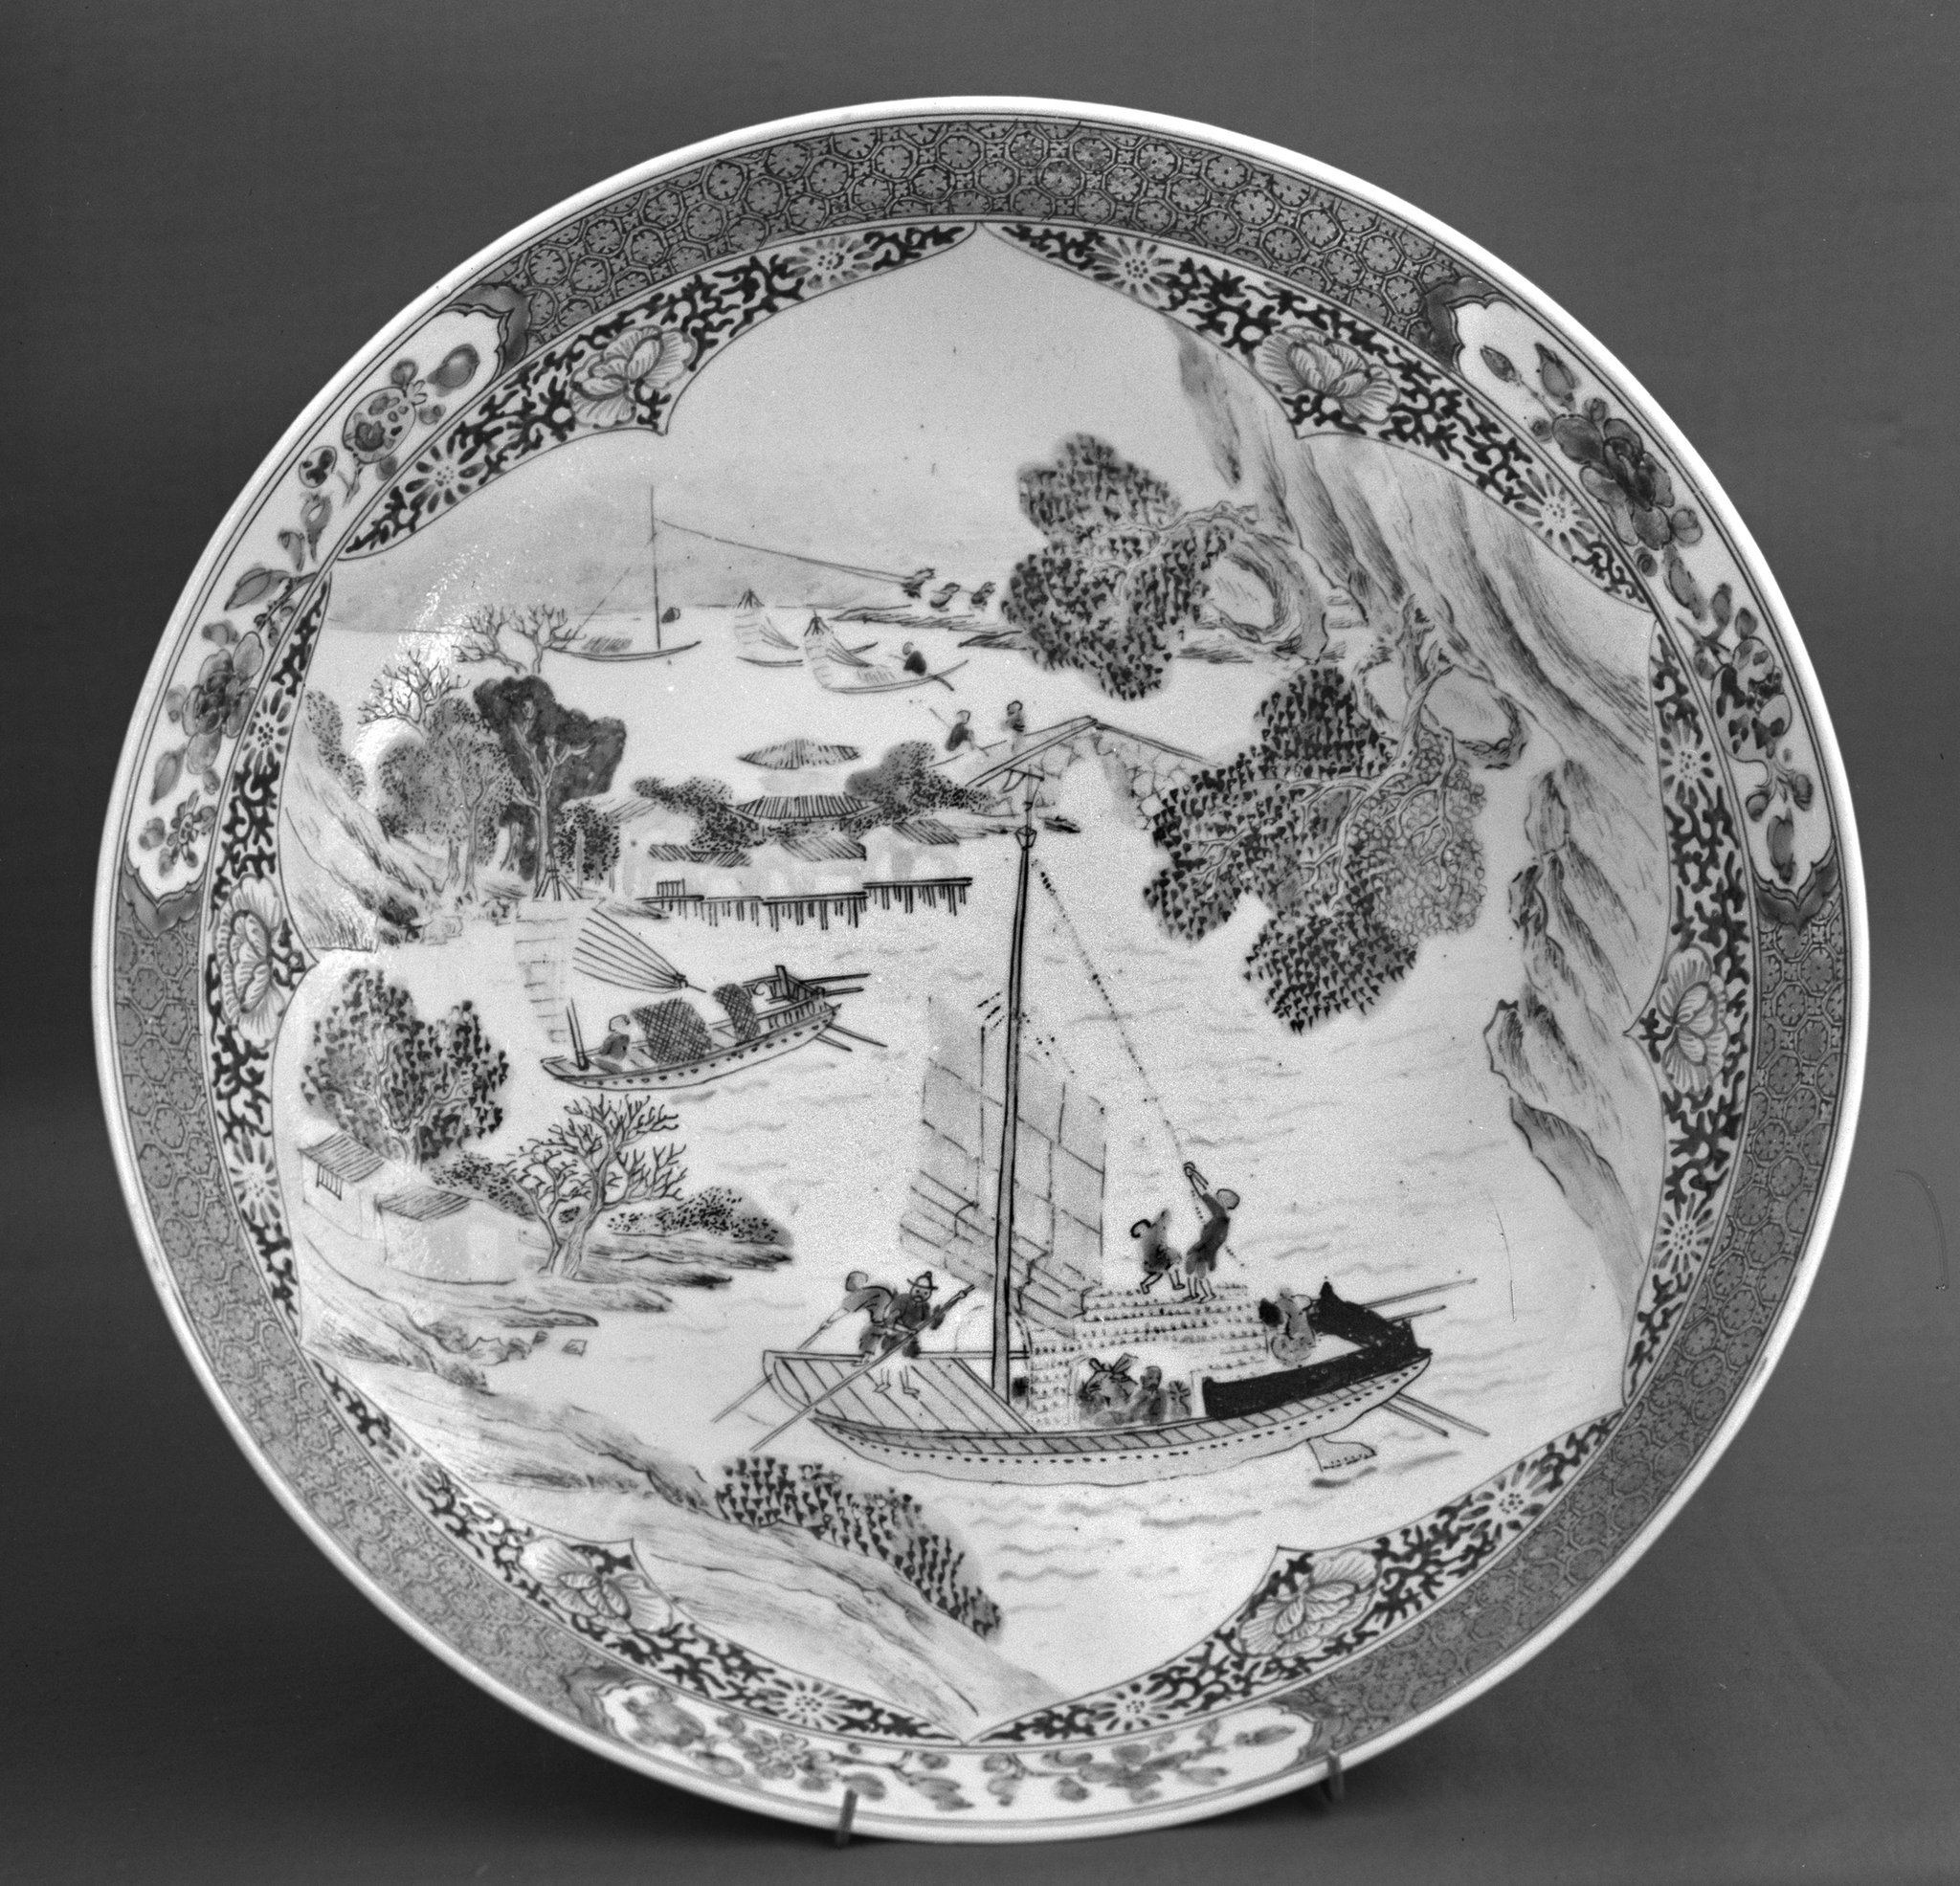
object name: dish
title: Dish with sailing-boat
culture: chinese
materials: enamel, porcelain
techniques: overglaze, painting, polychrome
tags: boats